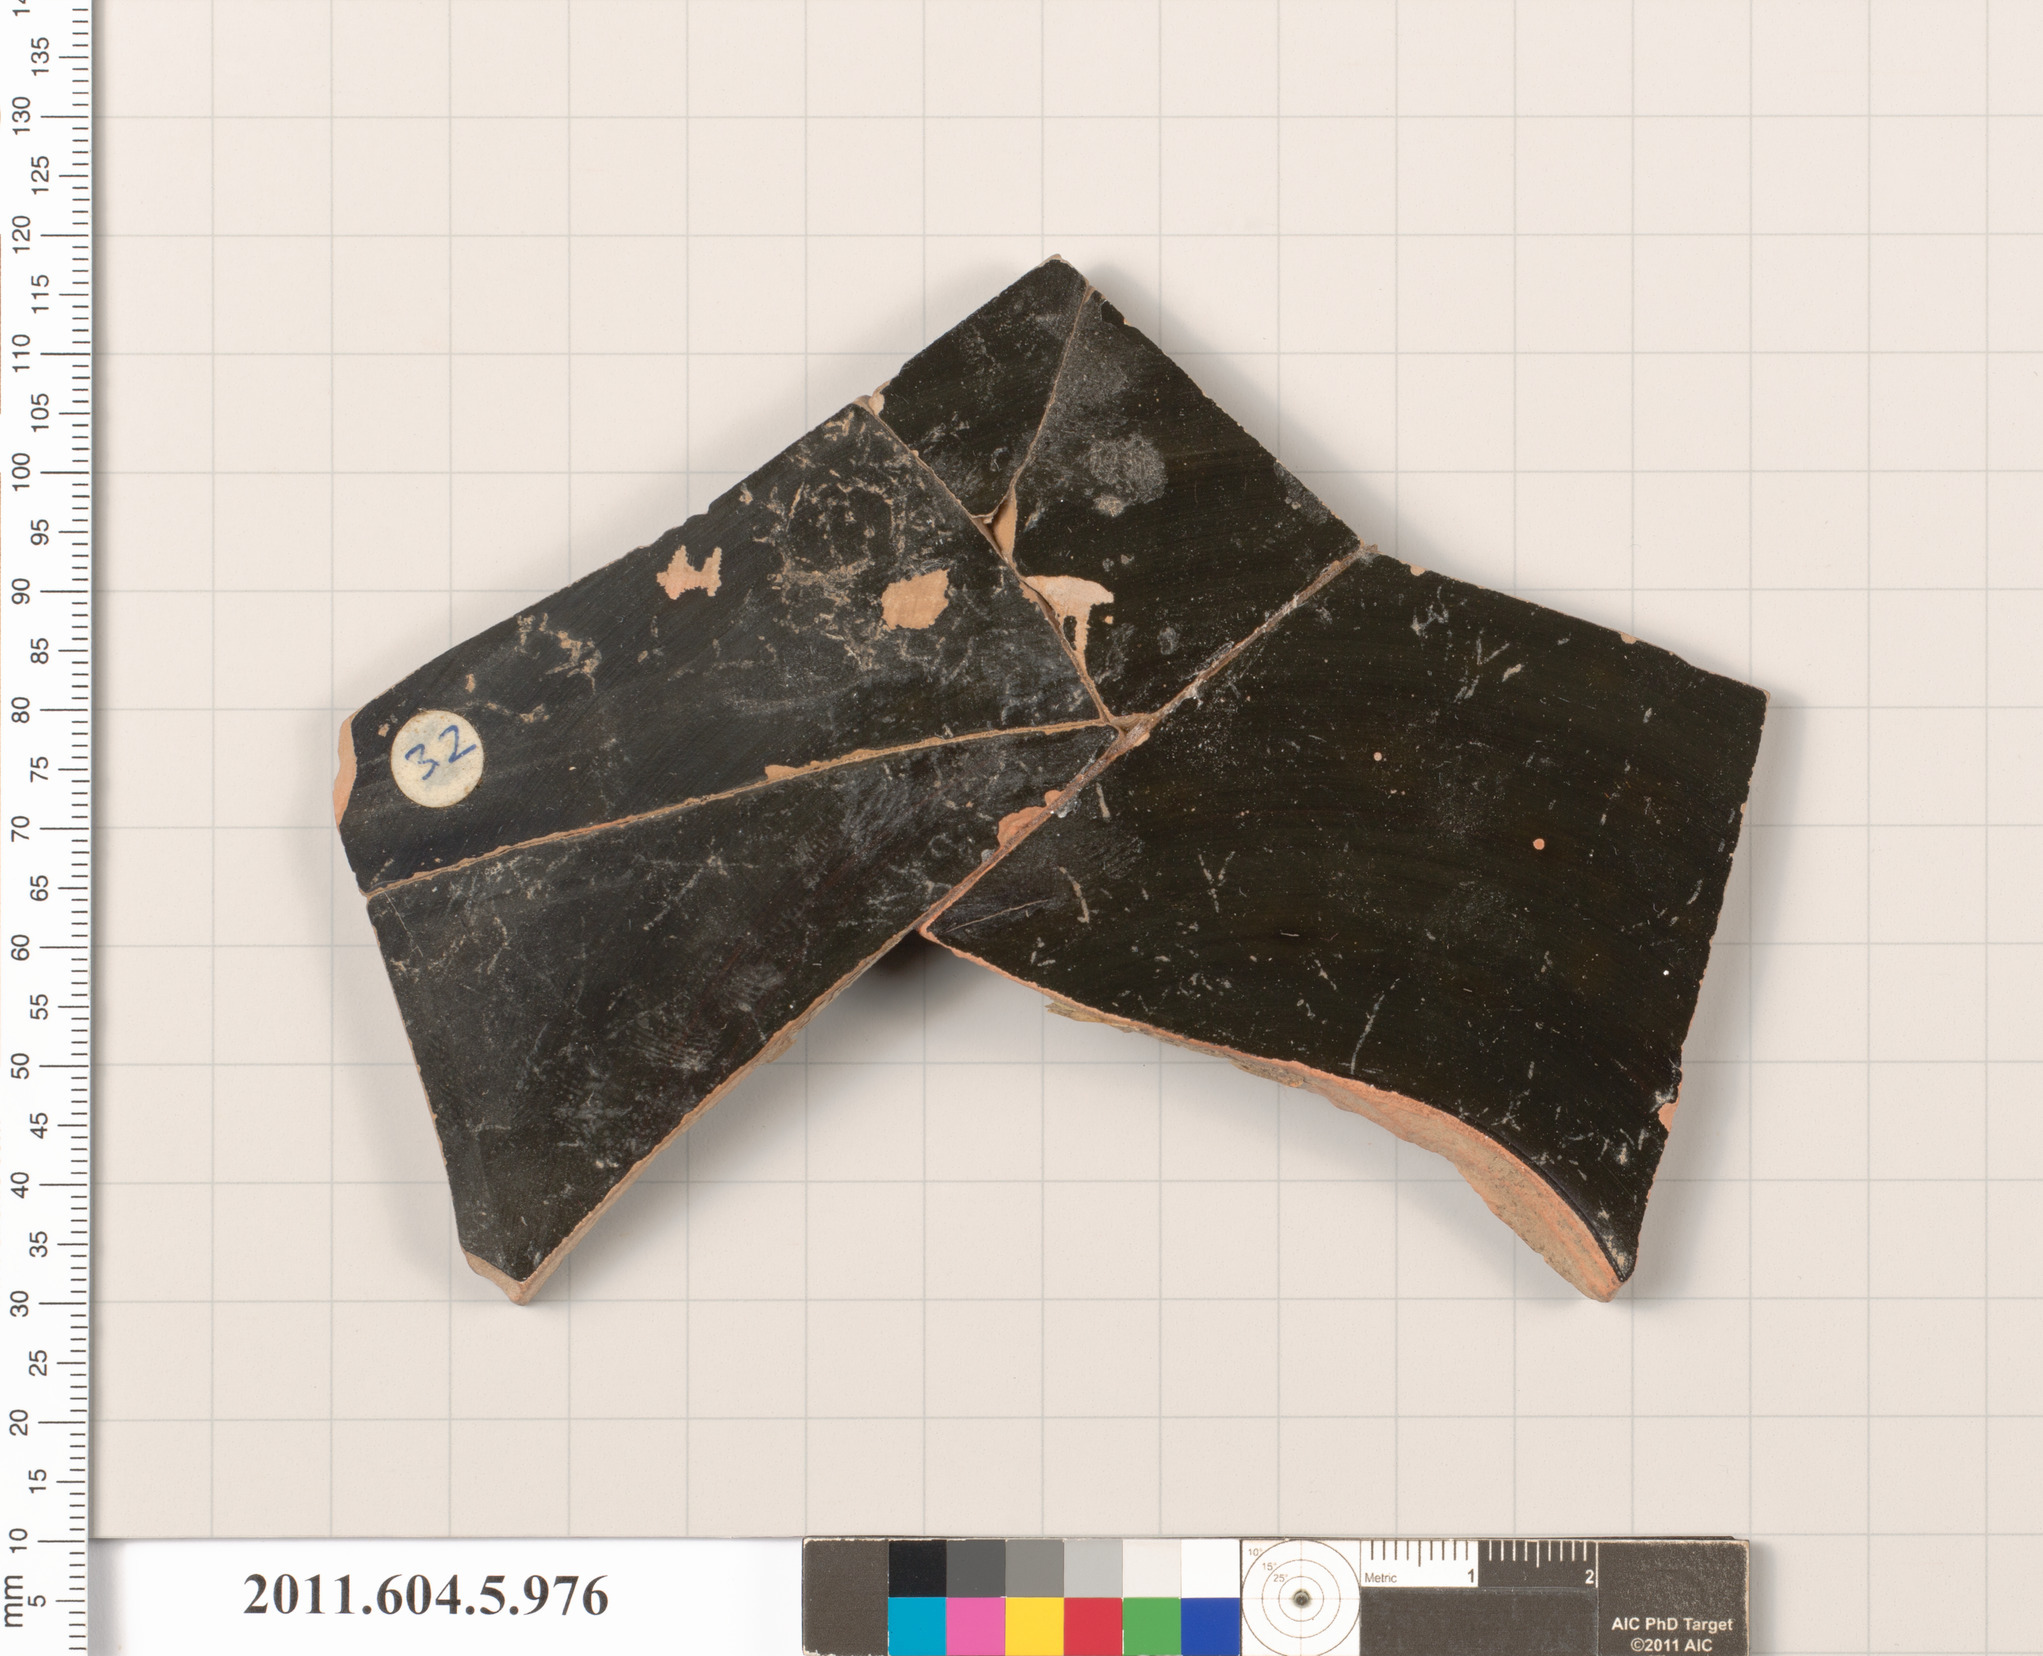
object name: kylix fragment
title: Terracotta fragment of a kylix (drinking cup)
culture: greek, attic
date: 600-401 BCE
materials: terracotta